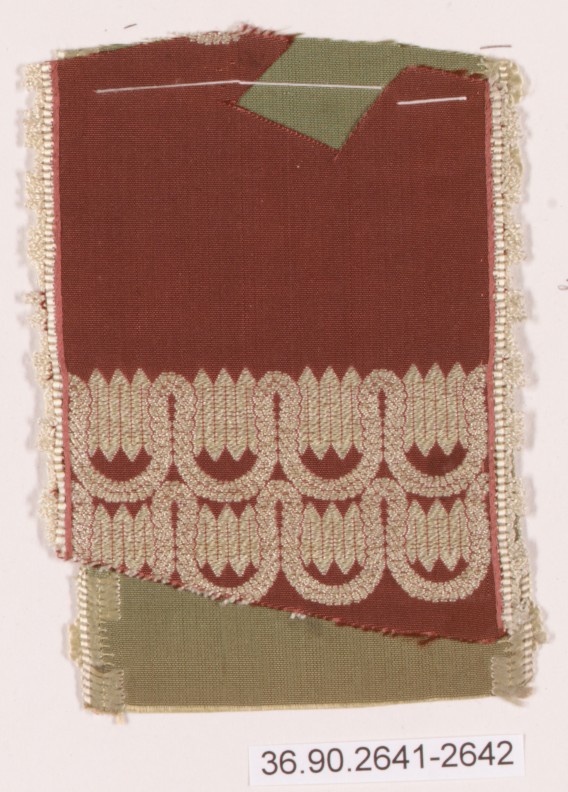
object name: ribbon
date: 1801-1900